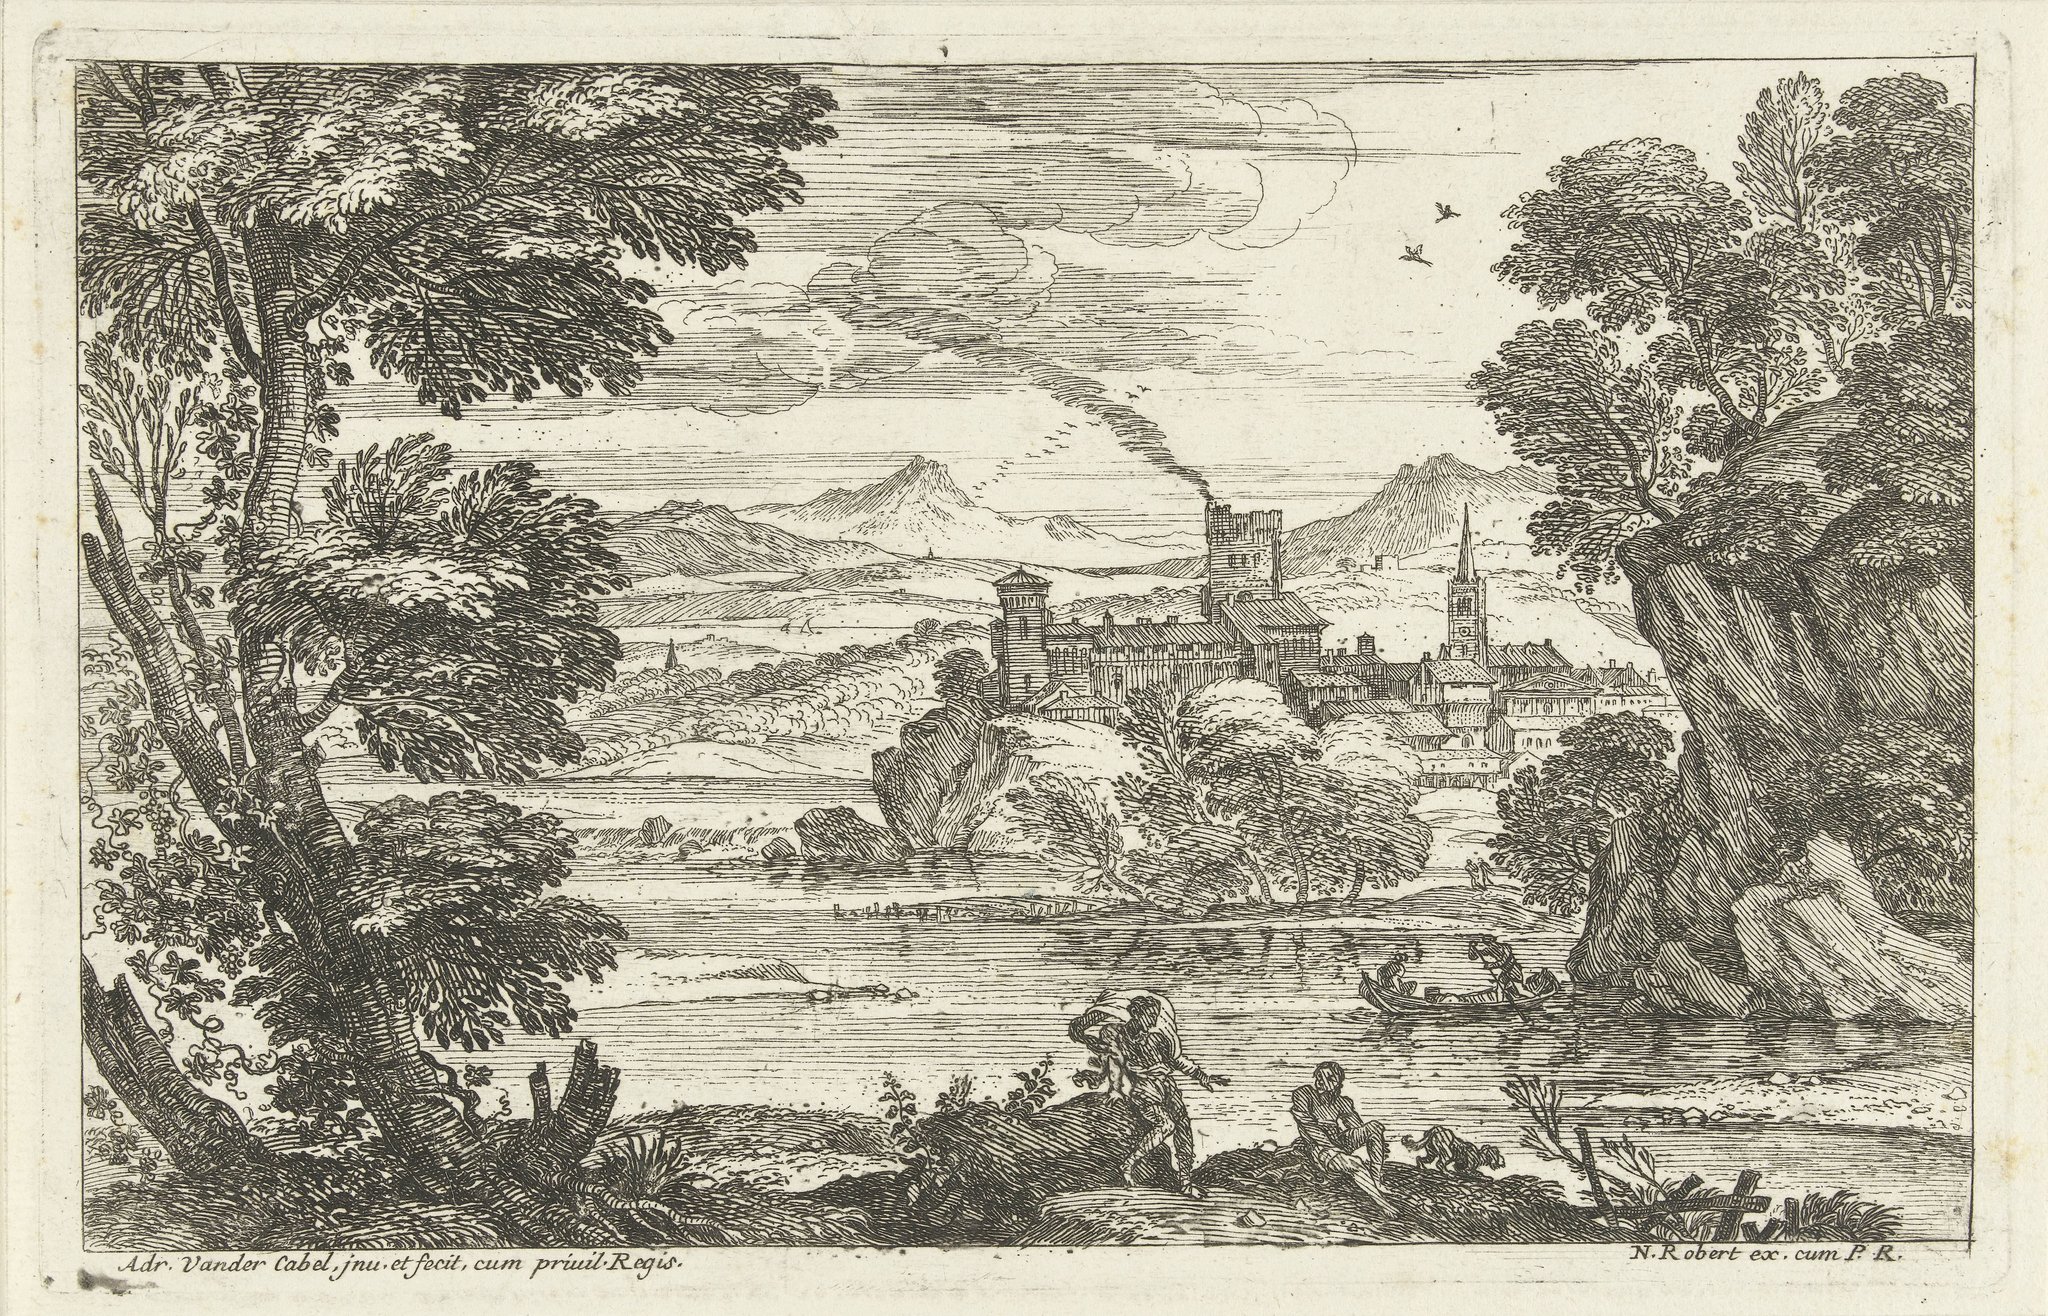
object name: print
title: Landschap met hond aan waterkant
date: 1648-1705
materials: paper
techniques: etching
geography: france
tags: landscapes, dog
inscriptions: collector's mark: Lugt 240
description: Landschap met op de voorgrond twee personen en een hond. Op de achtergrond een stad en een rivier waarin een gondel met twee personen. Vijfde prent uit de serie van zes.